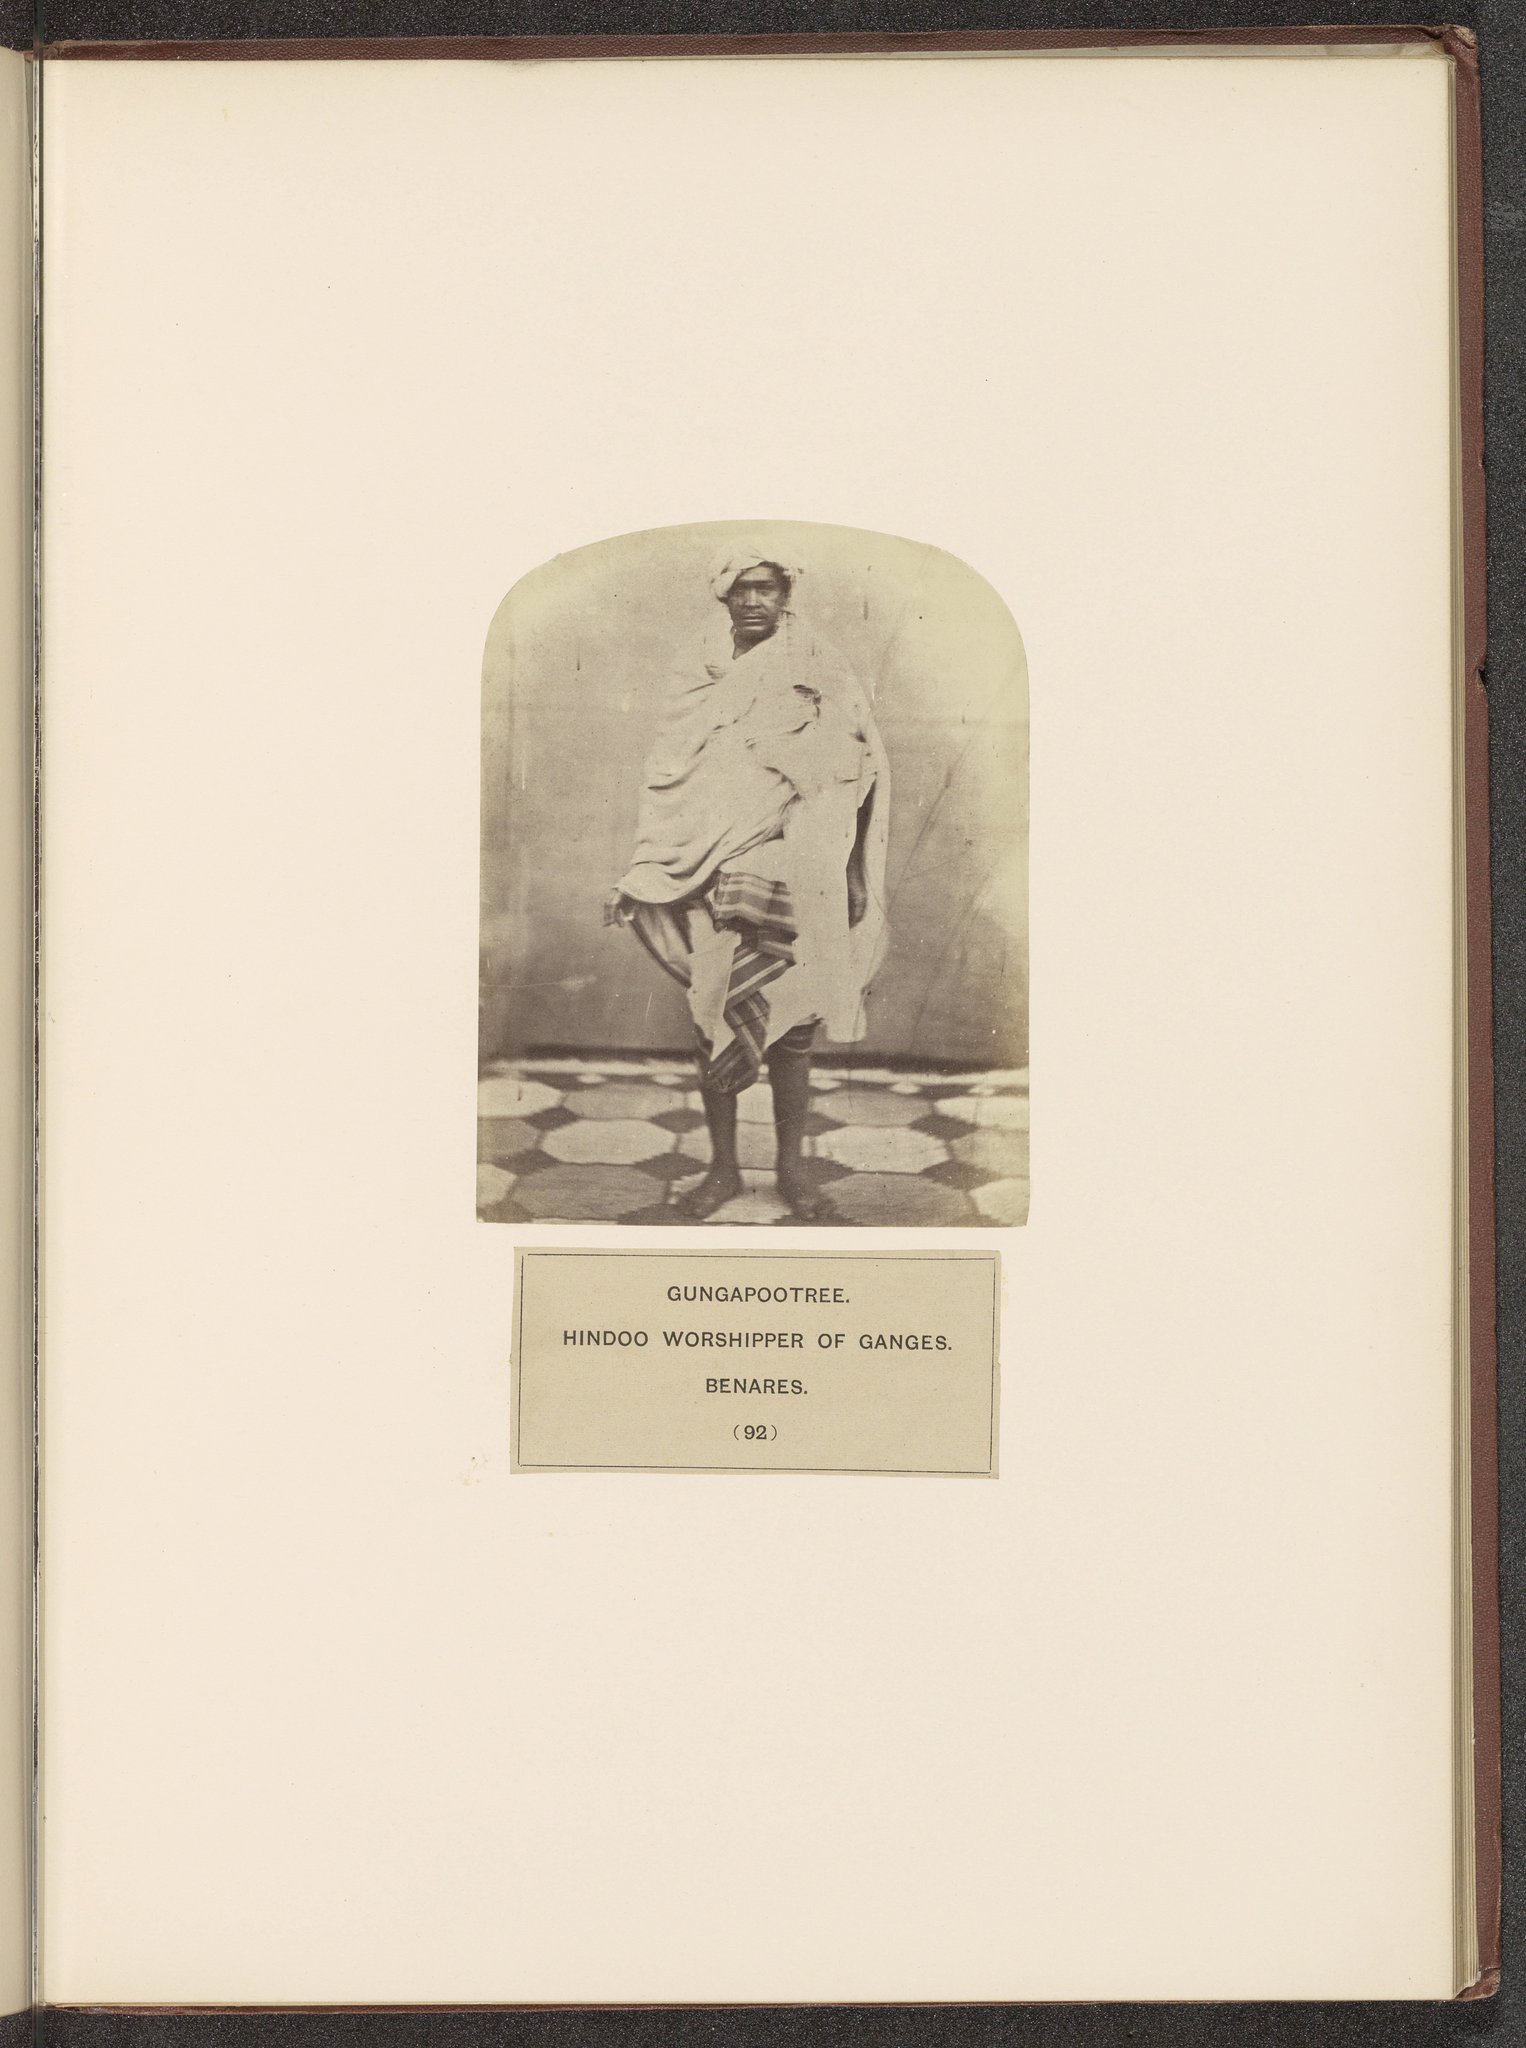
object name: page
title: Portrait of an unknown man from the Gangaputra Brahmin community of Varanasi, Uttar Pradesh, India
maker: Anonymous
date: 1858-1868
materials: photographic support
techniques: albumen print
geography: varanasi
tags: hinduism, buddhism, jainism, human races; peoples; nationalities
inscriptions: number: ‘(92)’, inscription: ‘GUNGAPOOTREE./ HINDOO WORSHIPPER OF GANGES./ BENARES.’